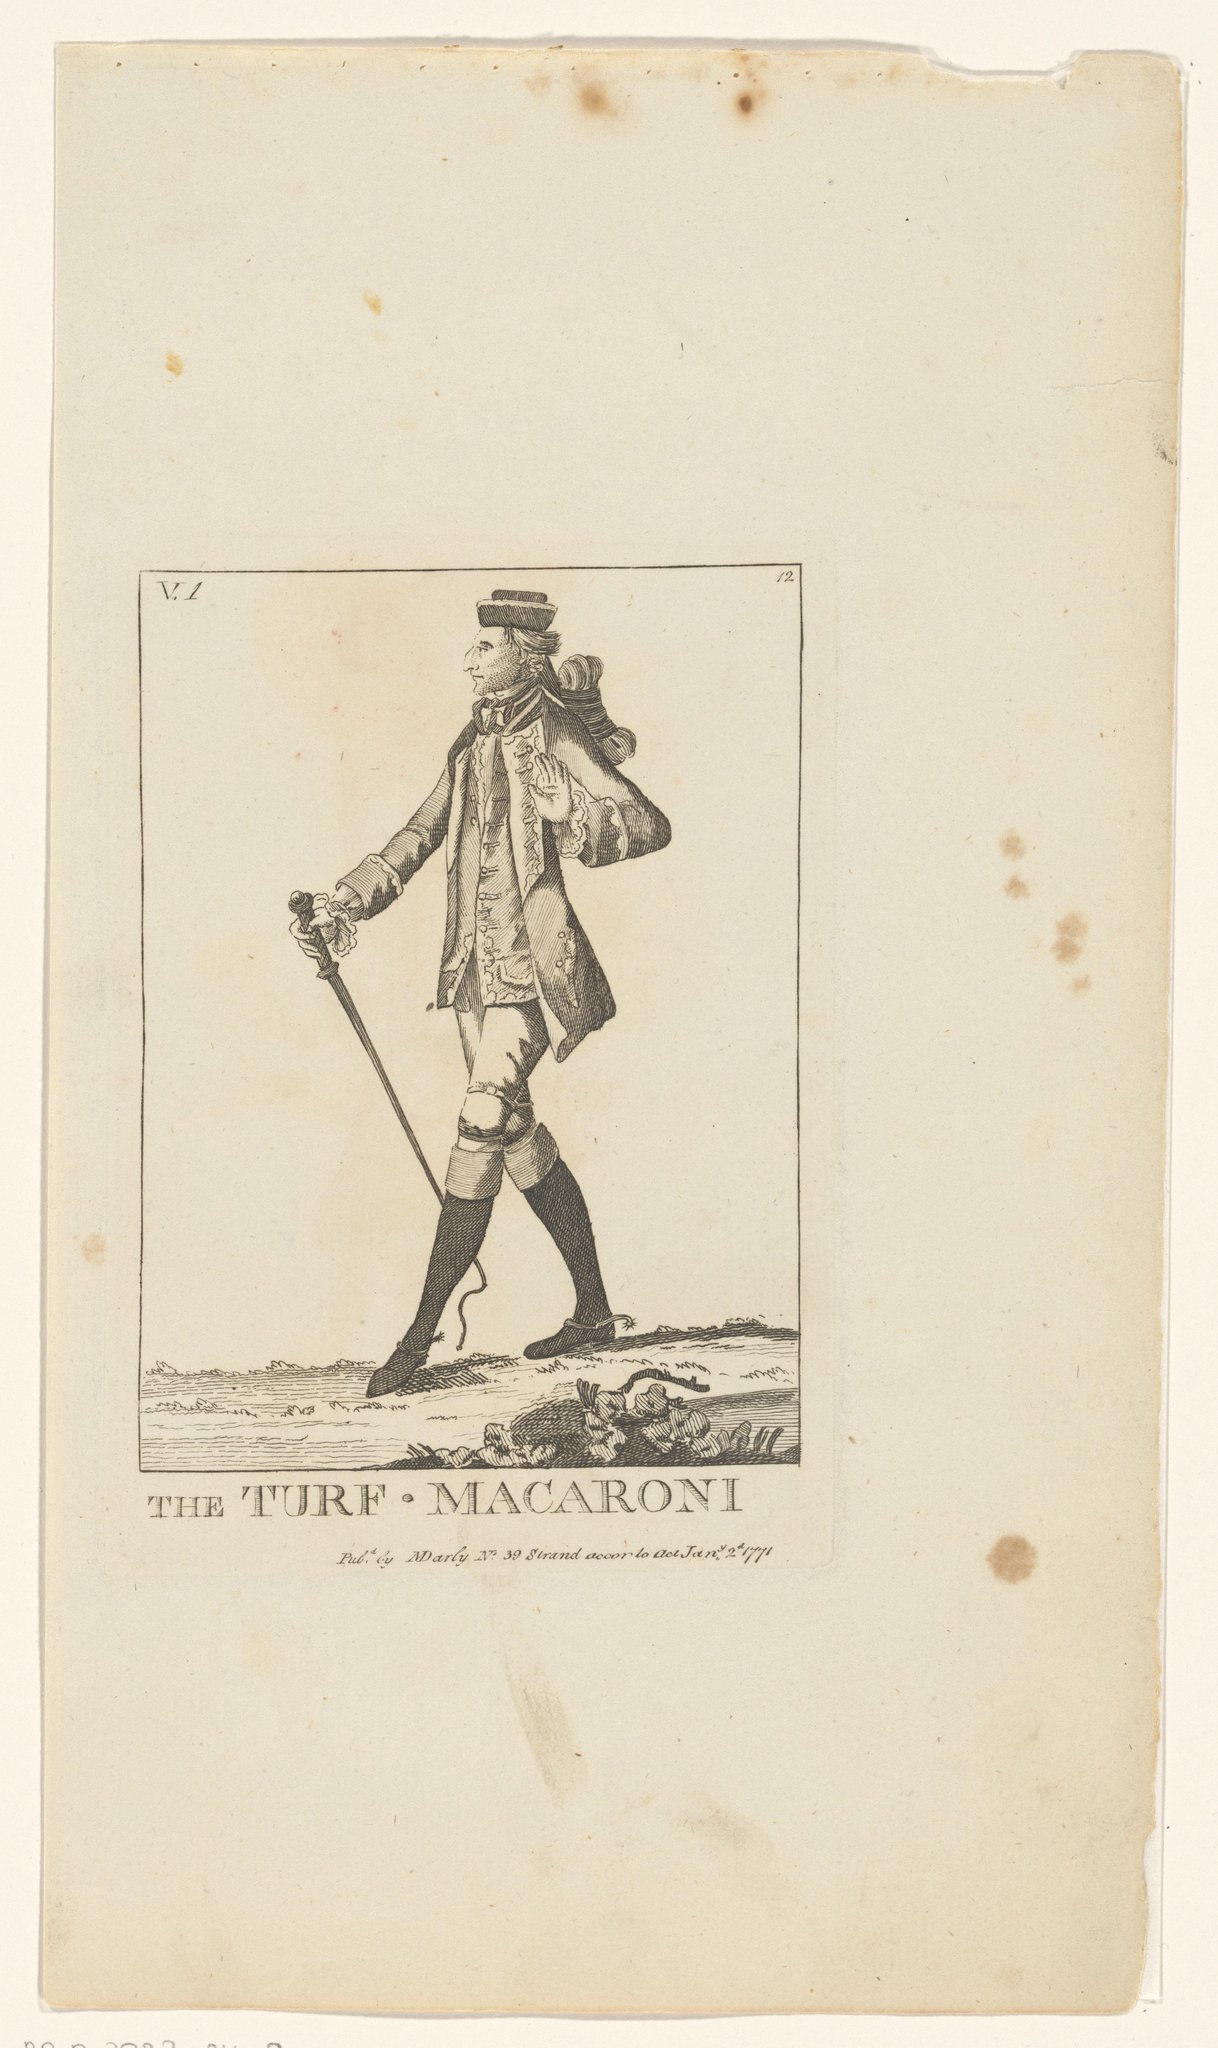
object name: cartoon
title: The Turf Macaroni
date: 1771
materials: paper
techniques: etching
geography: london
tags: politician, caricatures (human types), historical persons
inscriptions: collector's mark: Lugt 2228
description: Satire op Henry Fitzroy, 3rd Duke of Grafton. Portret ten voeten uit, lopend naar links in modieuze kleding. Hij draagt hoge rijlaarzen, de kousenband op zijn knie, een kleine hoed, zijn haar in een grote bos samengebonden op zijn rug en een lange rijzweep in de hand. Zijn kleding verwijst naar zijn grote liefde voor het paardenrennen. Prent nummer 12 uit de eerste van zes sets van elk 24 karikaturen van verschillende dames, heren, kunstenaars, enz., uitgegeven door de Darly’s.